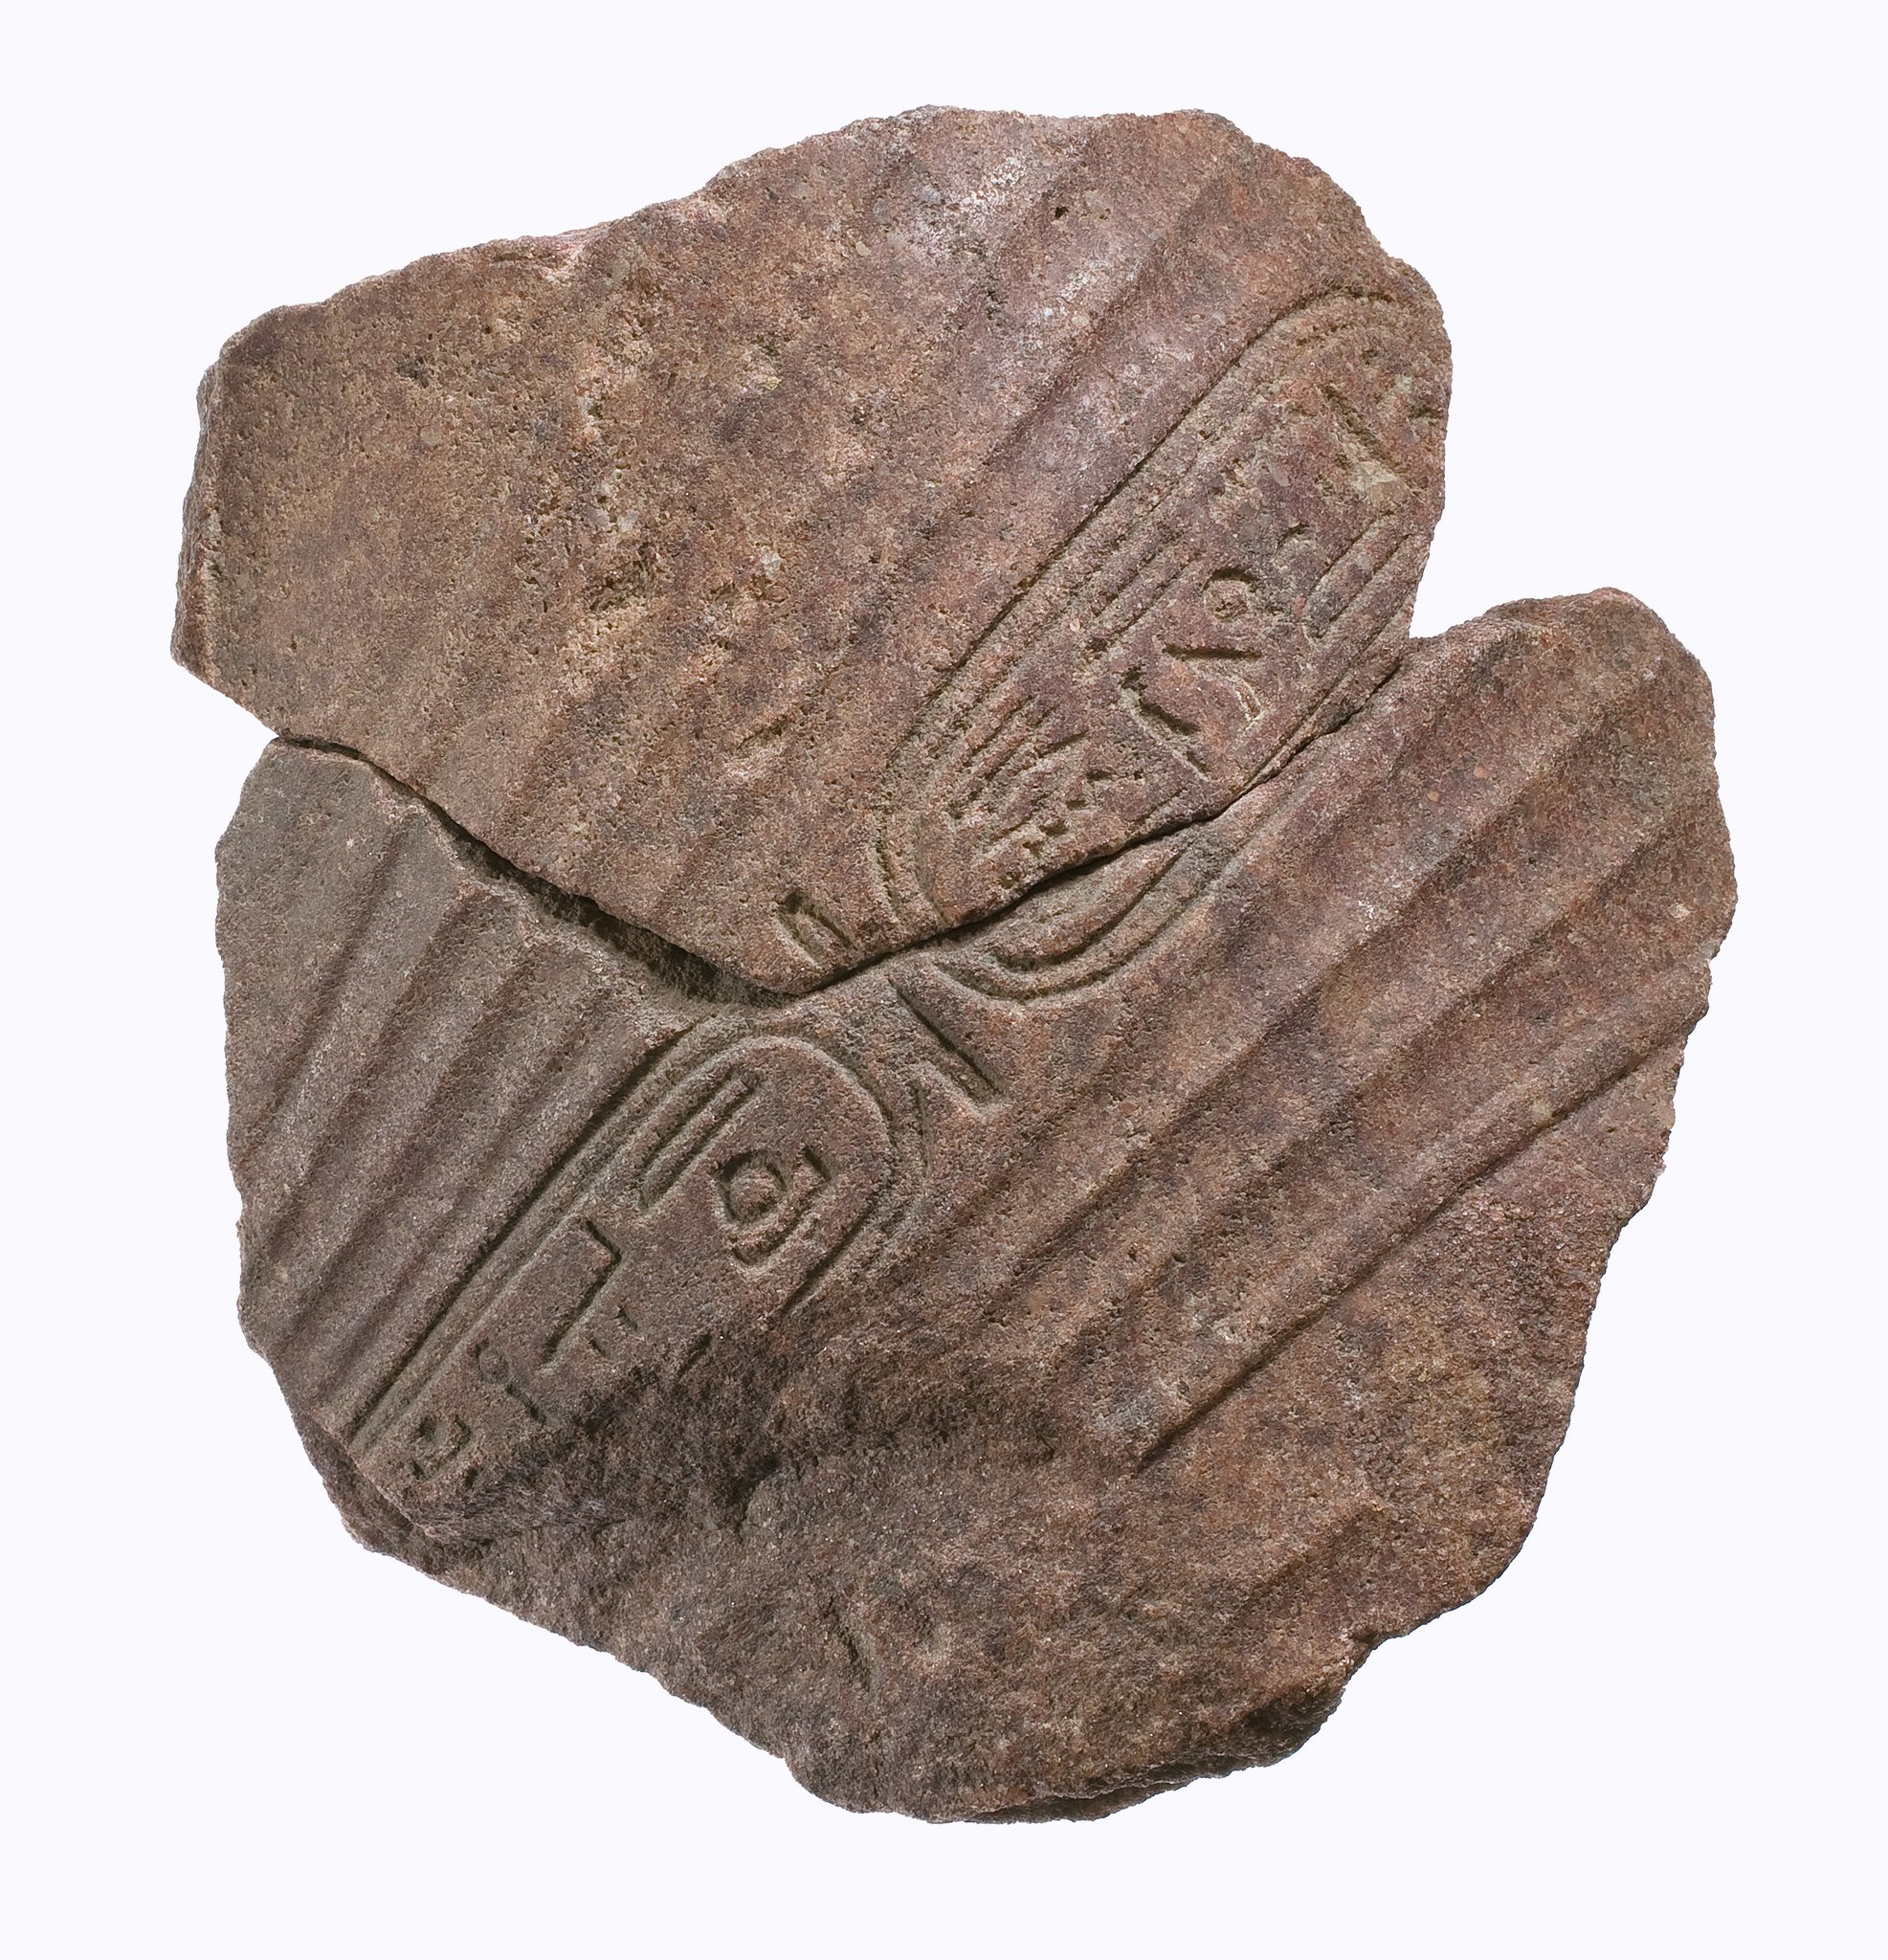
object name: waist, royal kilt, aten cartouch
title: waist area from a statue of the king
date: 1353-1336 BCE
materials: quartzite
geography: egypt